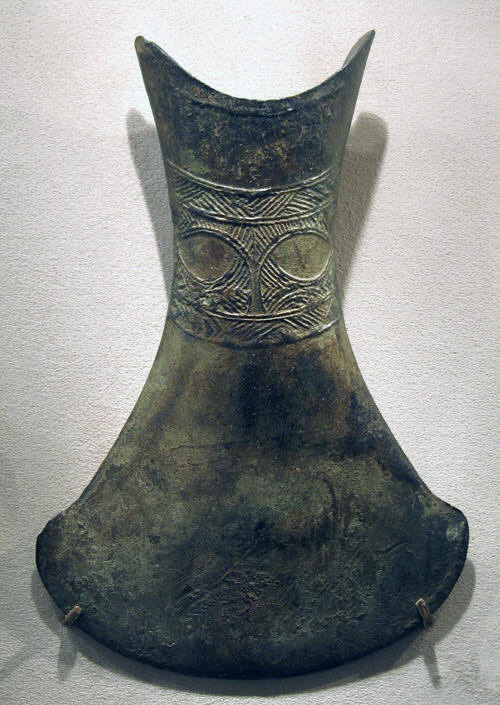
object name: ax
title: Hafted Ax with Abstract Face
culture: indonesian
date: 500 BCE-300 CE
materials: bronze